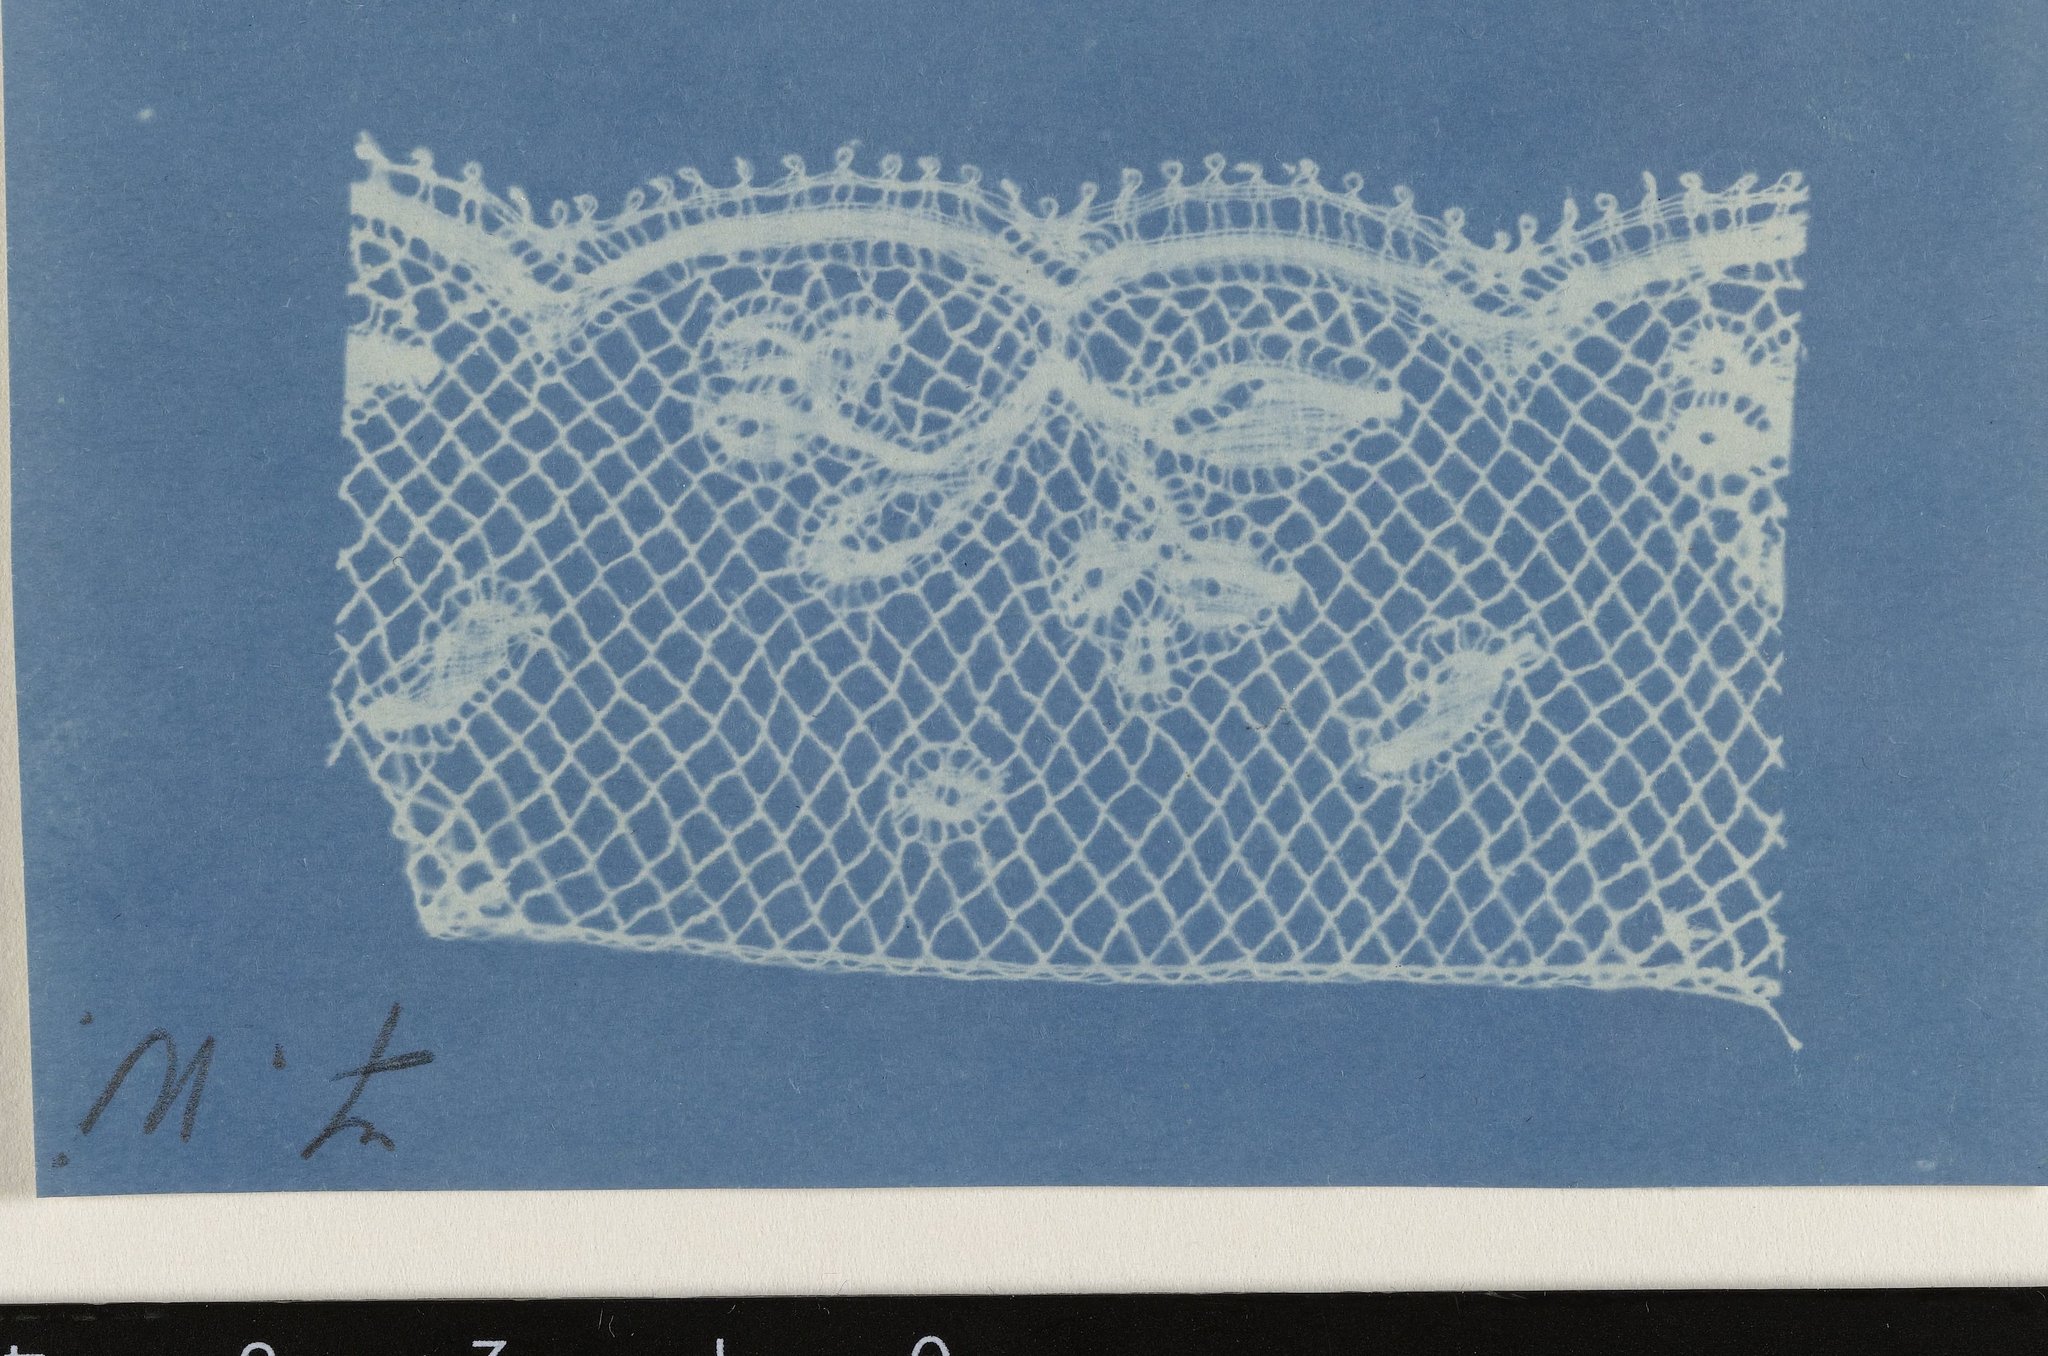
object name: photogram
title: Kant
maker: Anonymous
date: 1890-1925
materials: photographic support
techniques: cyanotype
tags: lace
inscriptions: annotation: ‘7.W.’